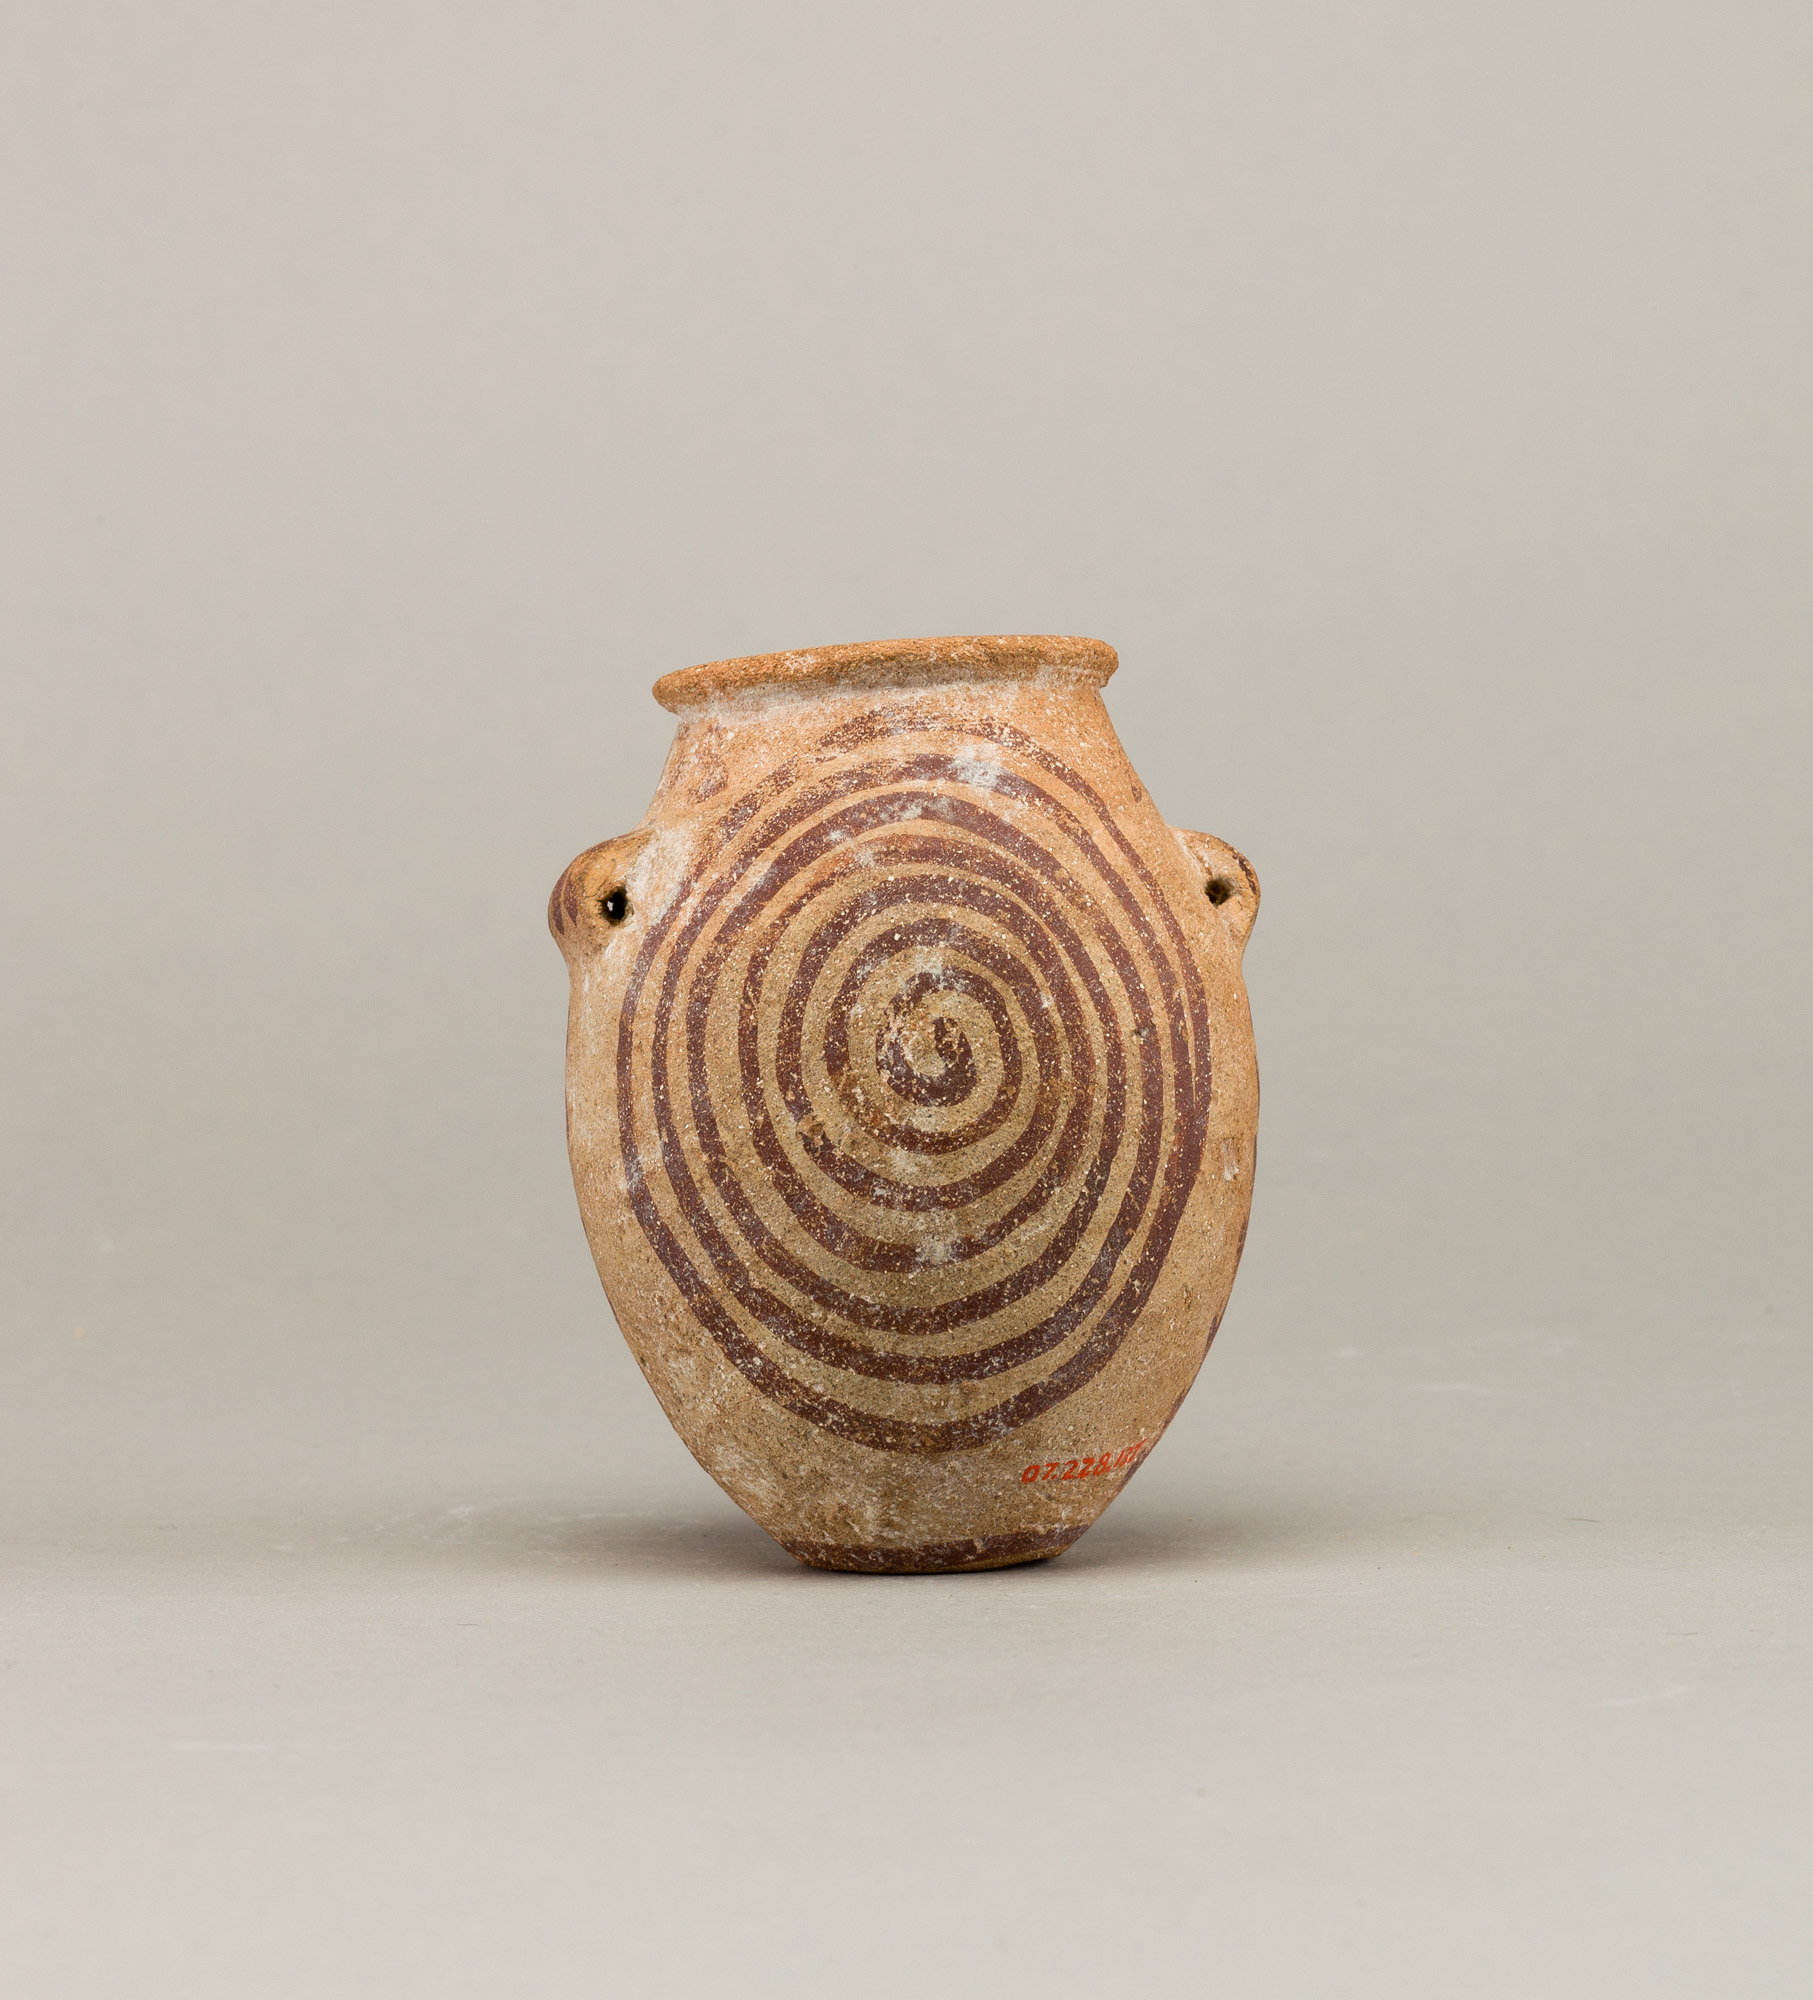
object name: jar, decorated ware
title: Decorated ware jar depicting spirals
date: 3850-2960 BCE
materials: paint, pottery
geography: egypt